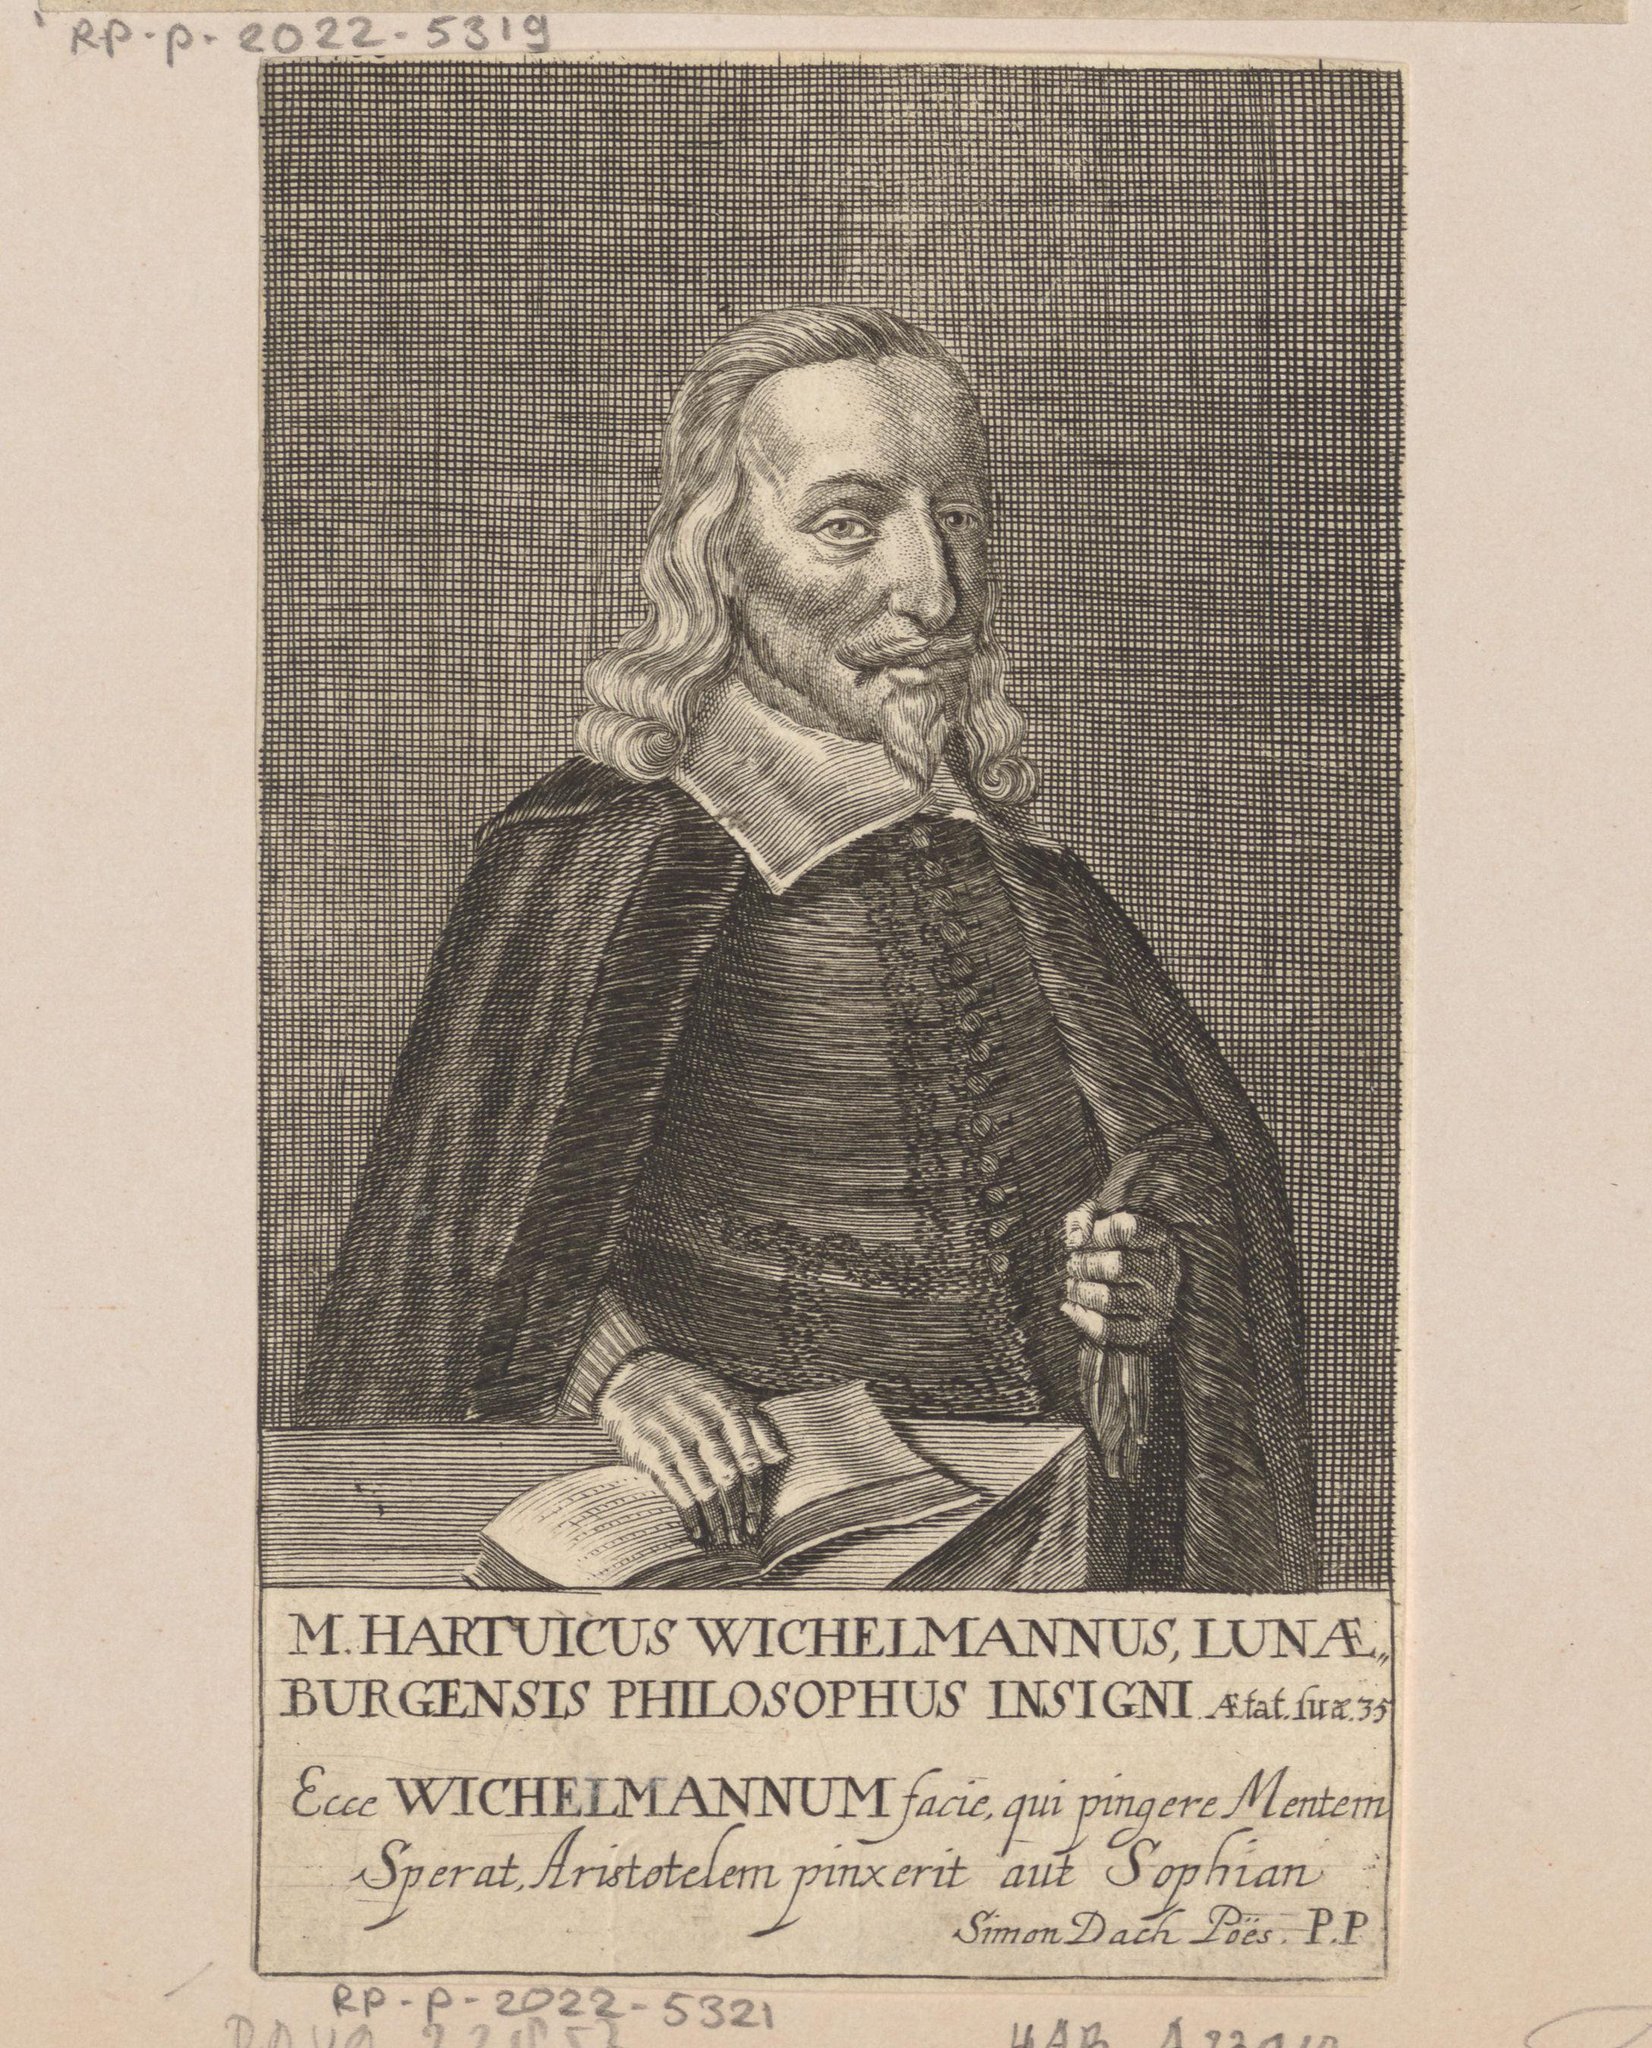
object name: print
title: Portret van Hartwig Wichelmann op 35-jarige leeftijd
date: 1694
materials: paper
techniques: engraving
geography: germany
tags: historical persons, professor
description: Prent waarschijnlijk uit: Kongehl, Michael. Immergrünender Cypressen-Hayn (...). Danzig: Martin Hallervord, 1694.